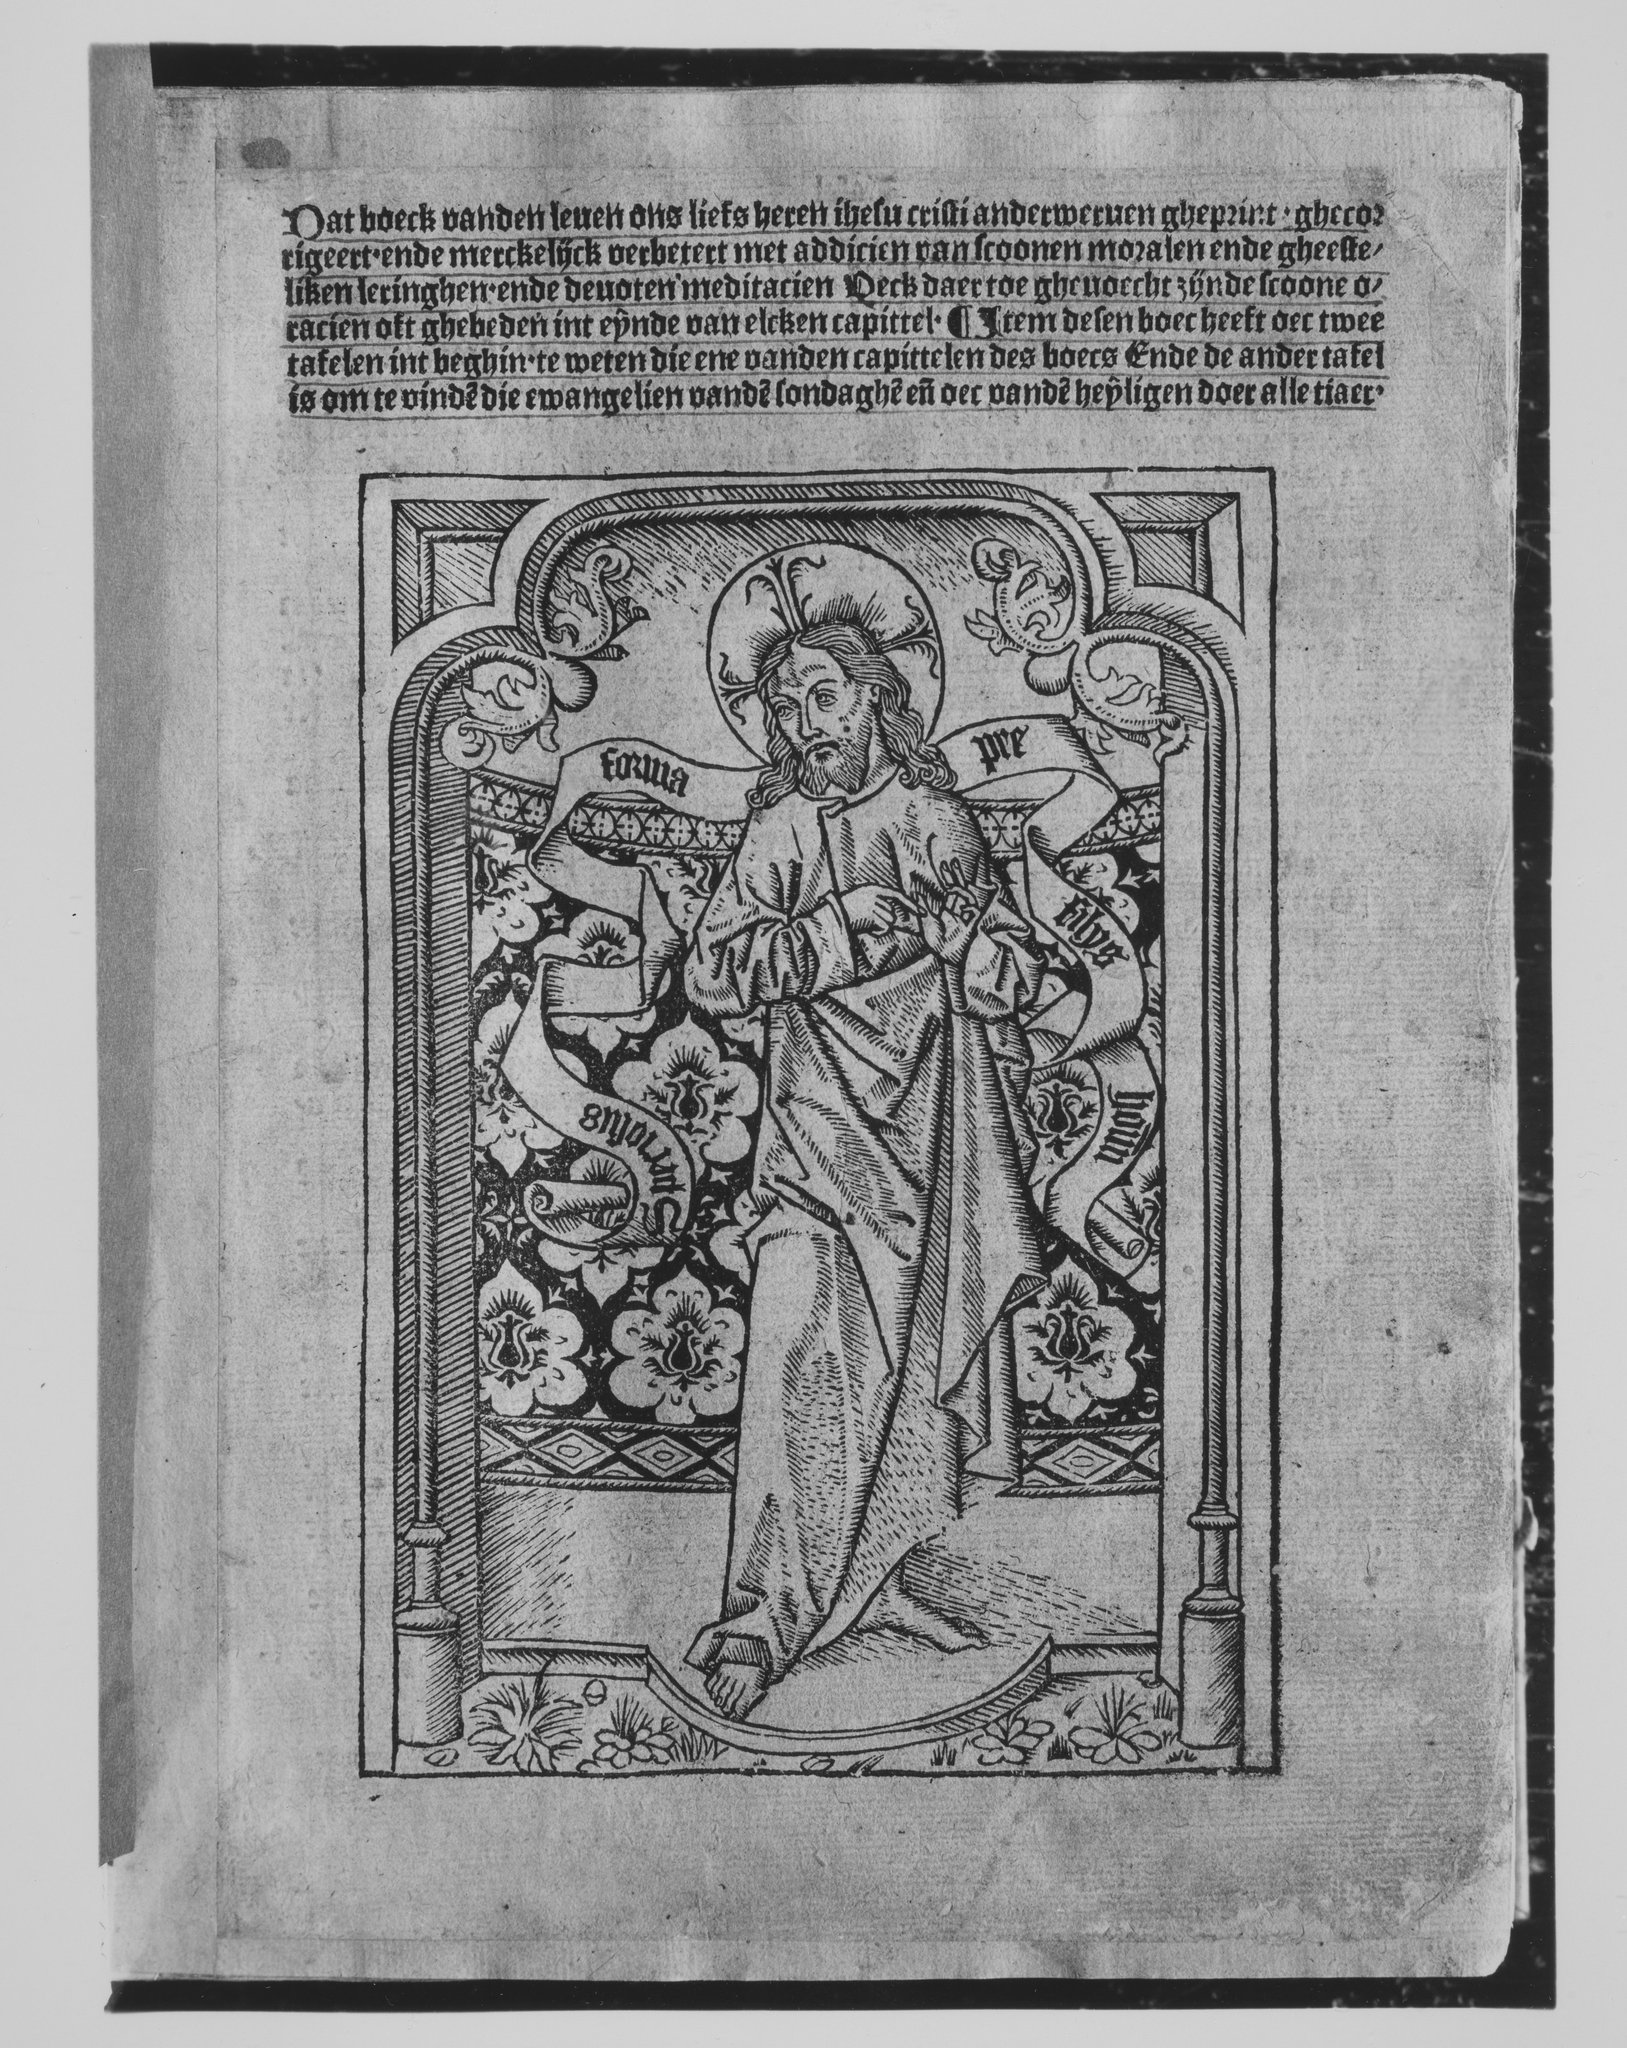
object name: book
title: Dat boeck van dem leuen ons liefs heren ihesu cristi...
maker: ludolphus de saxonia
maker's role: author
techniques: woodcut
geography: zwolle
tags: christ